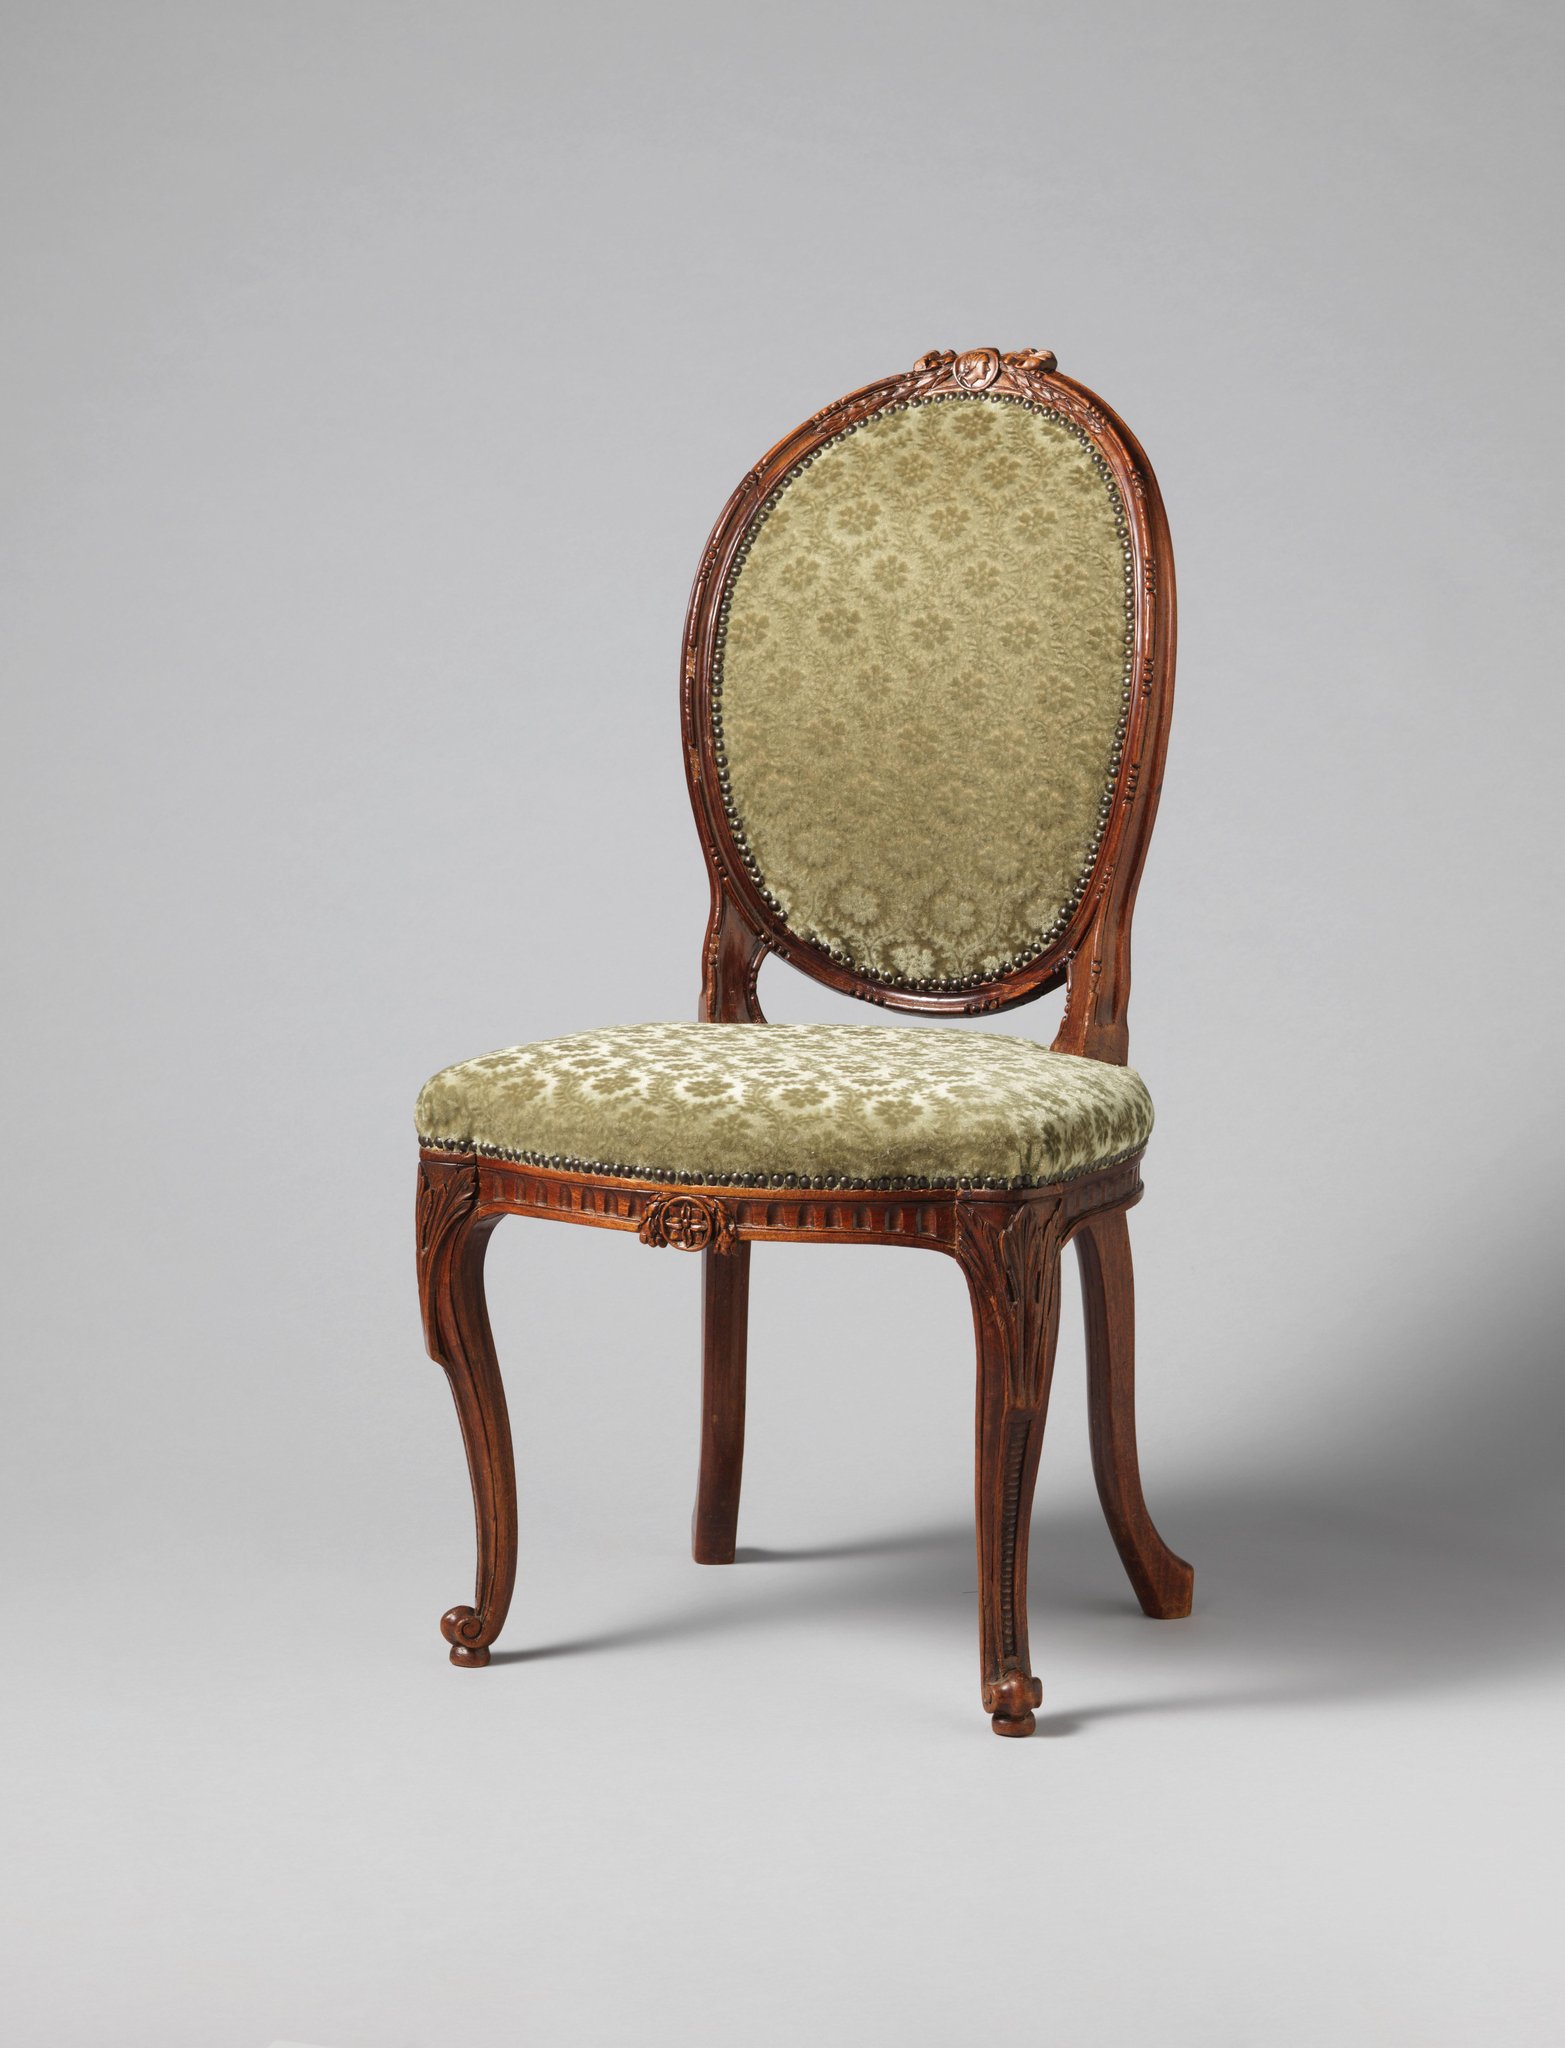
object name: furniture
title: Stoel met in de kap van de rug een in profiel gesneden vrouwenkop binnen een medaillon met ter weerszijden lauwerslingers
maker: Anonymous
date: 1775-1780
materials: wood, textile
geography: netherlands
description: Stoel van mahoniehout, bekleed met groene trijp (niet oorspronkelijk). De twee licht S-vormig gebogen poten zijn versierd met een geribde band die wordt bekroond door een groot motief an acanthusbladeren. De krachtig gebogen achterpoten zijn onversierd. De rechte zitregel vertoont aan voorzijde en zijkanten cannelures, in het midden van de voorzijde onderbroken door een rond medaillon met rozet waarvan ter weerszijden laurierslingers afhangen. Langs de ovale, licht holle rug en de hoge, C-vormig gebogen steunen daarvan lopt een lijst van afwisselend staven en drie parels. Deze wordt aan de bovenzijde onderbroken door een rond medaillon met een vrouwenkop in profiel, naar rechts gewend,hangend aan een strik en ter weerszijden geflankeerd door afhangende lauwerslingers.